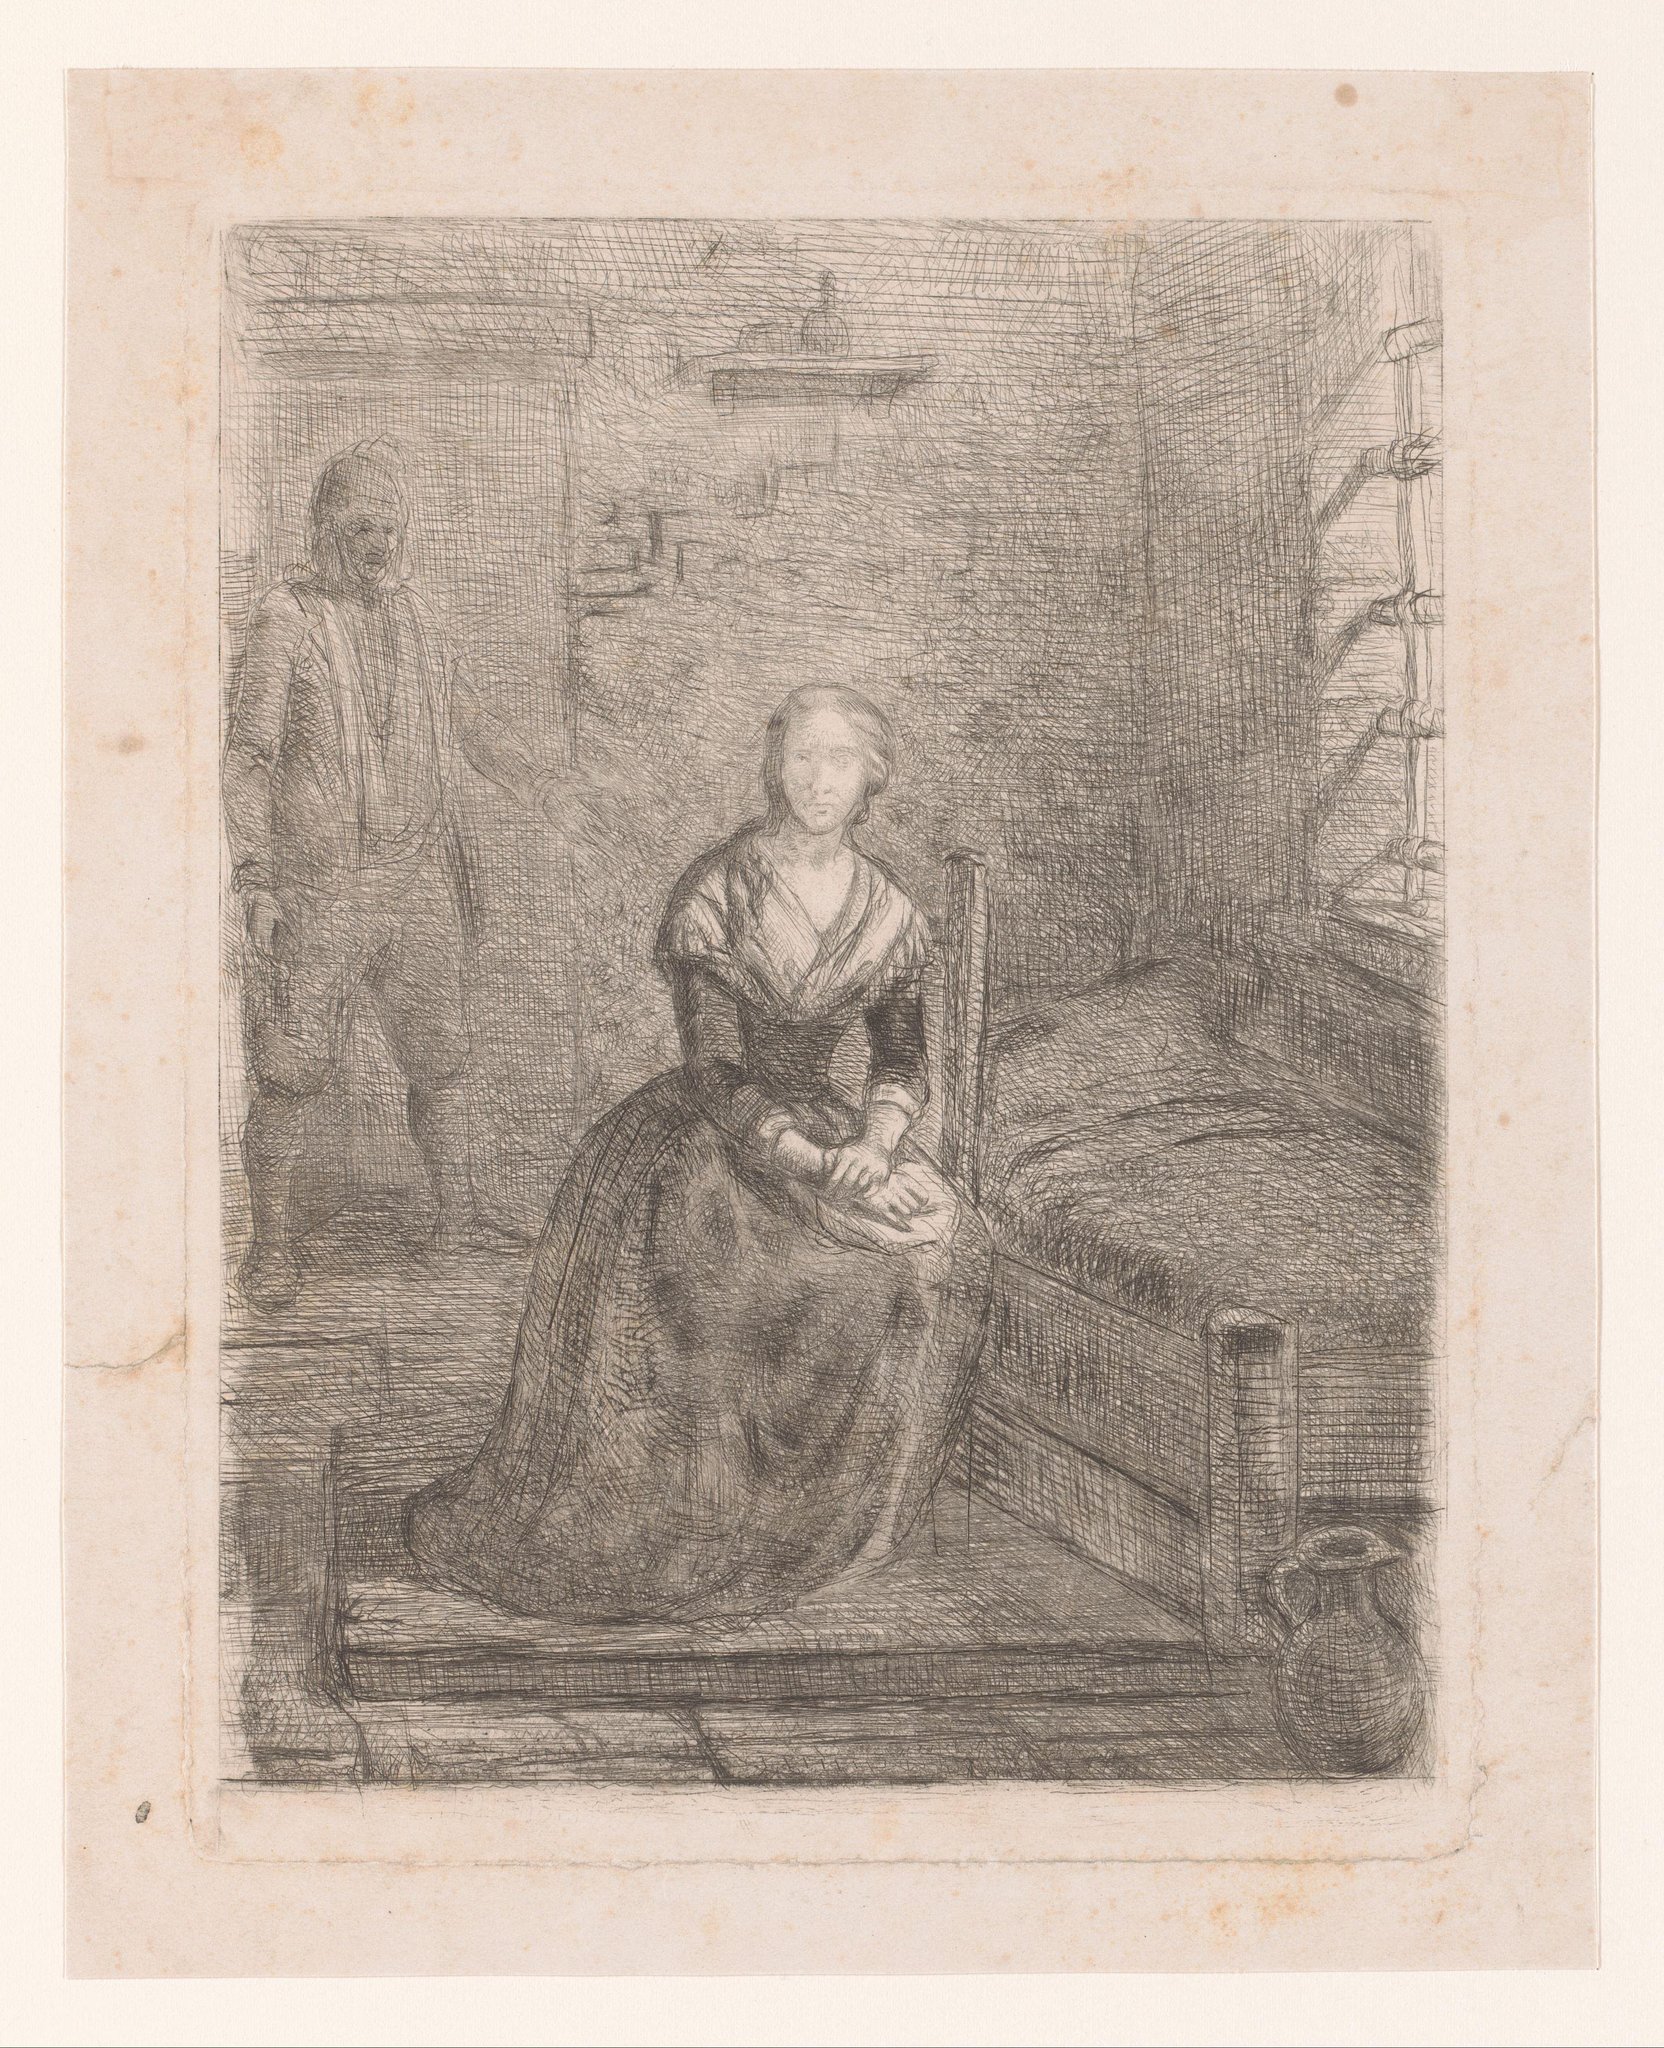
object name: print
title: Marie Antoinette gevangen in de Tour du Temple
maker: charles augustin wauters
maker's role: draughtsman, print maker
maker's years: 1811-1869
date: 1821-1869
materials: paper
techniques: etching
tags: vienna, paris, marie antoinette, adult woman, bed, imprisonment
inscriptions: collector's mark: Lugt 2228, collector's mark: Lugt 1485